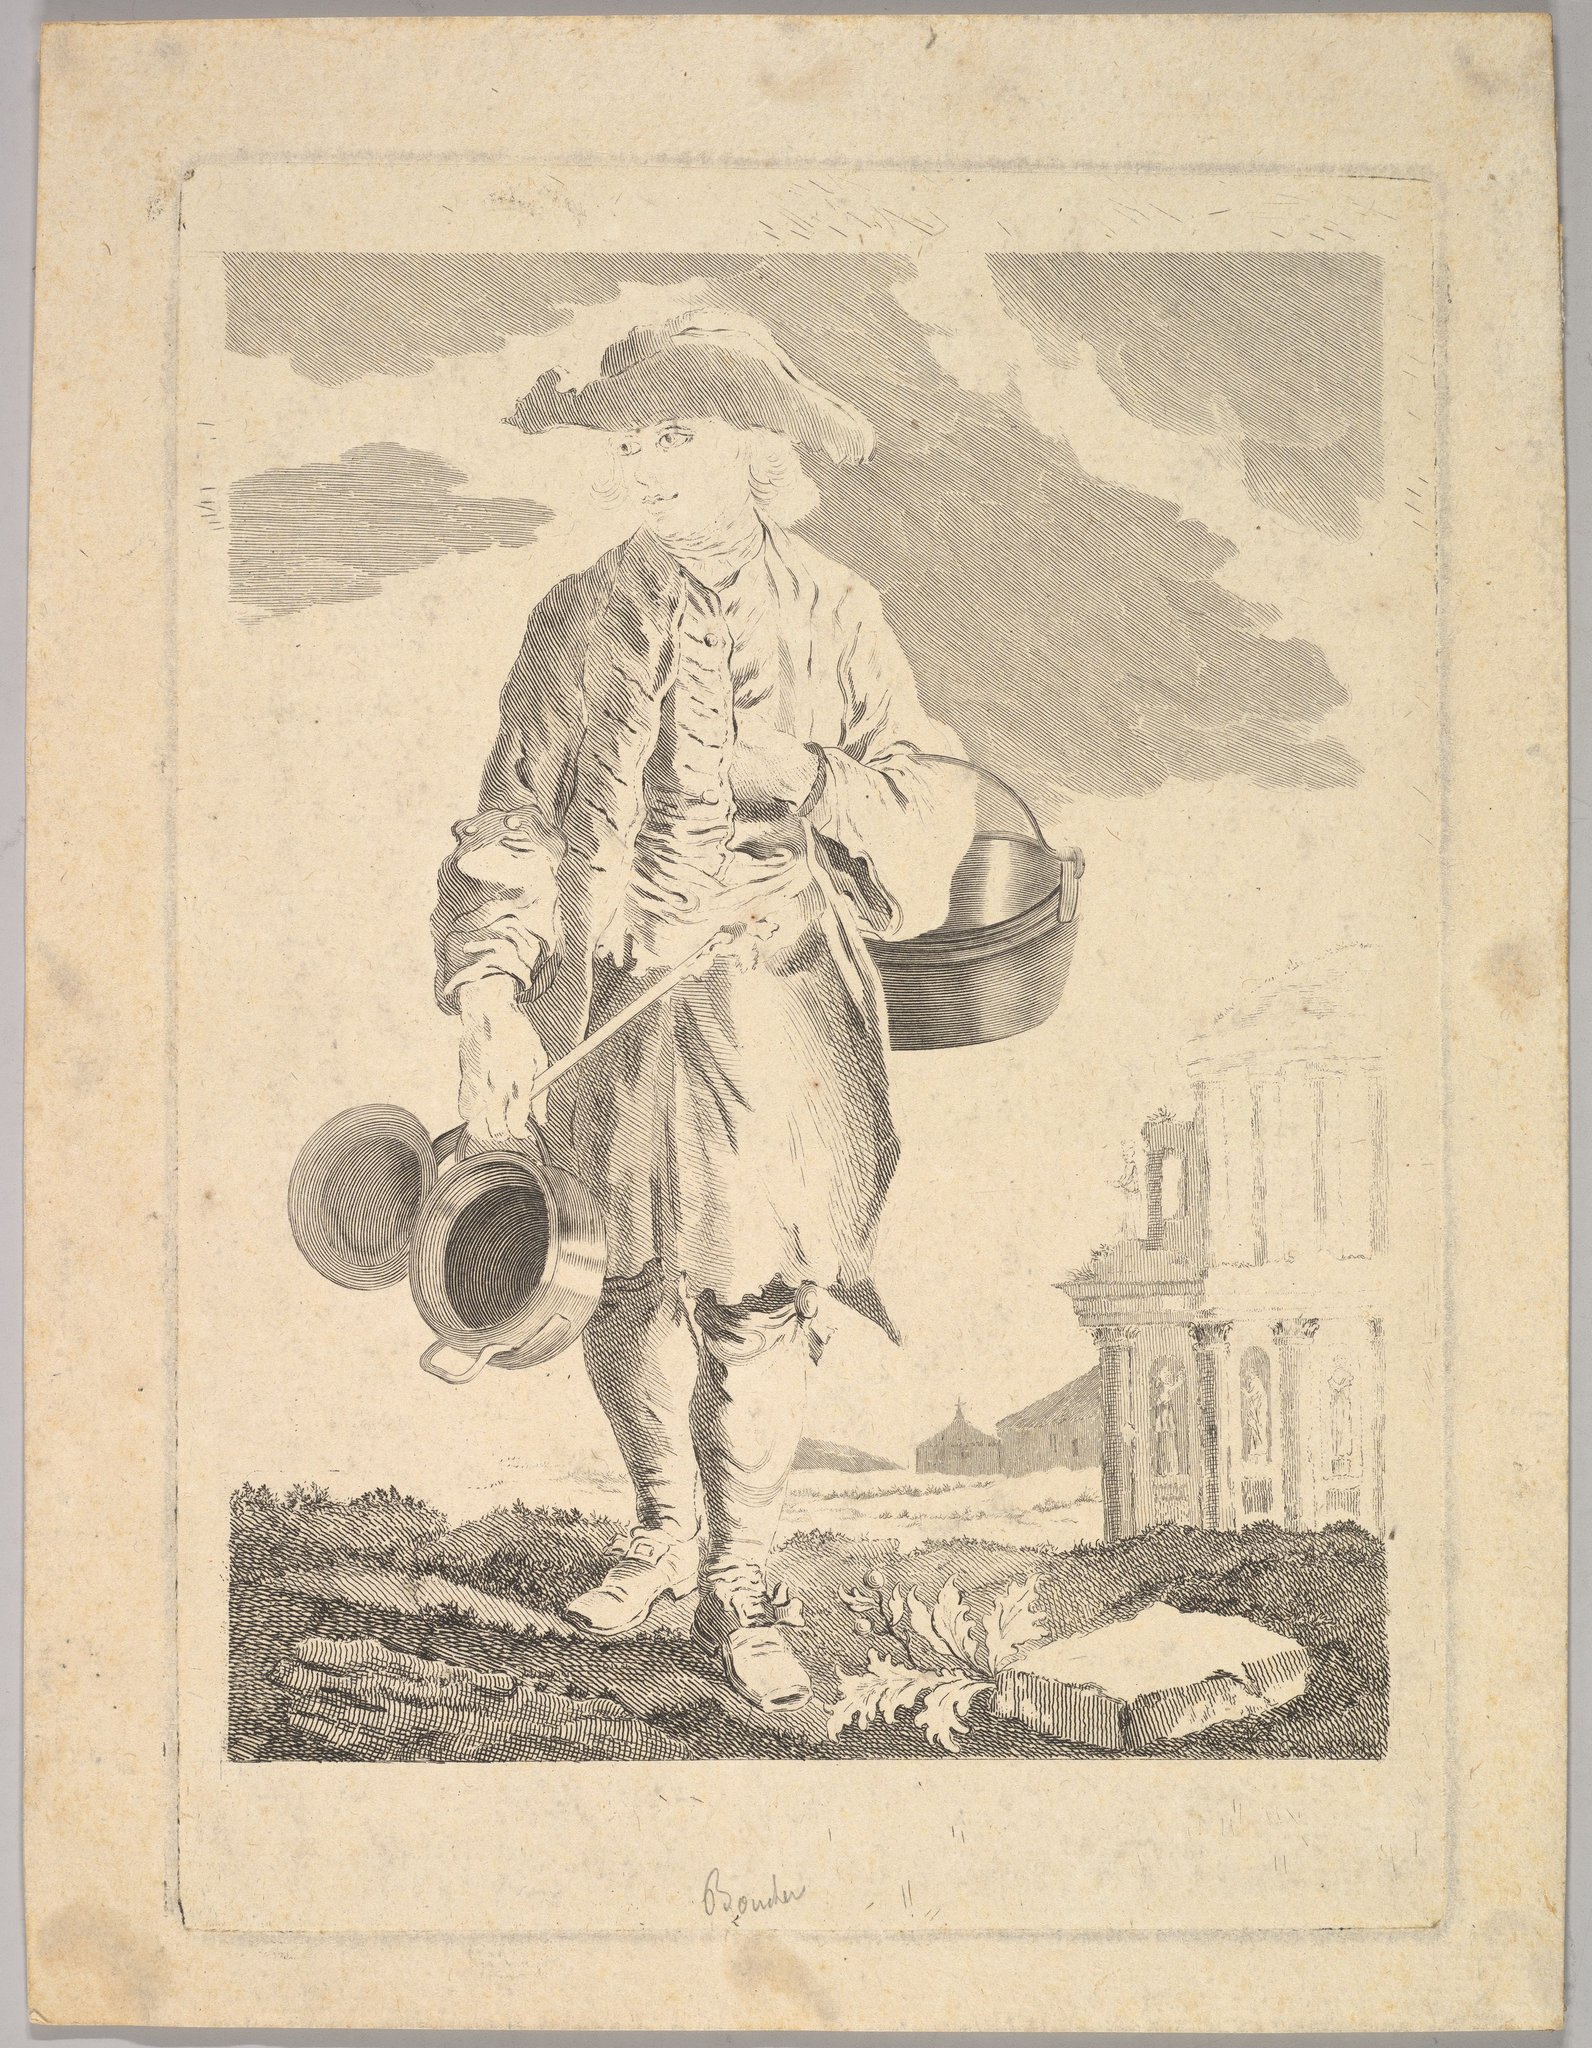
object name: print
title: Standing man holding kettles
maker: anonymous, french, 18th century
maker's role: artist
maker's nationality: french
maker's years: 1700-1800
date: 1701-1800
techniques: etching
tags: men,kettles